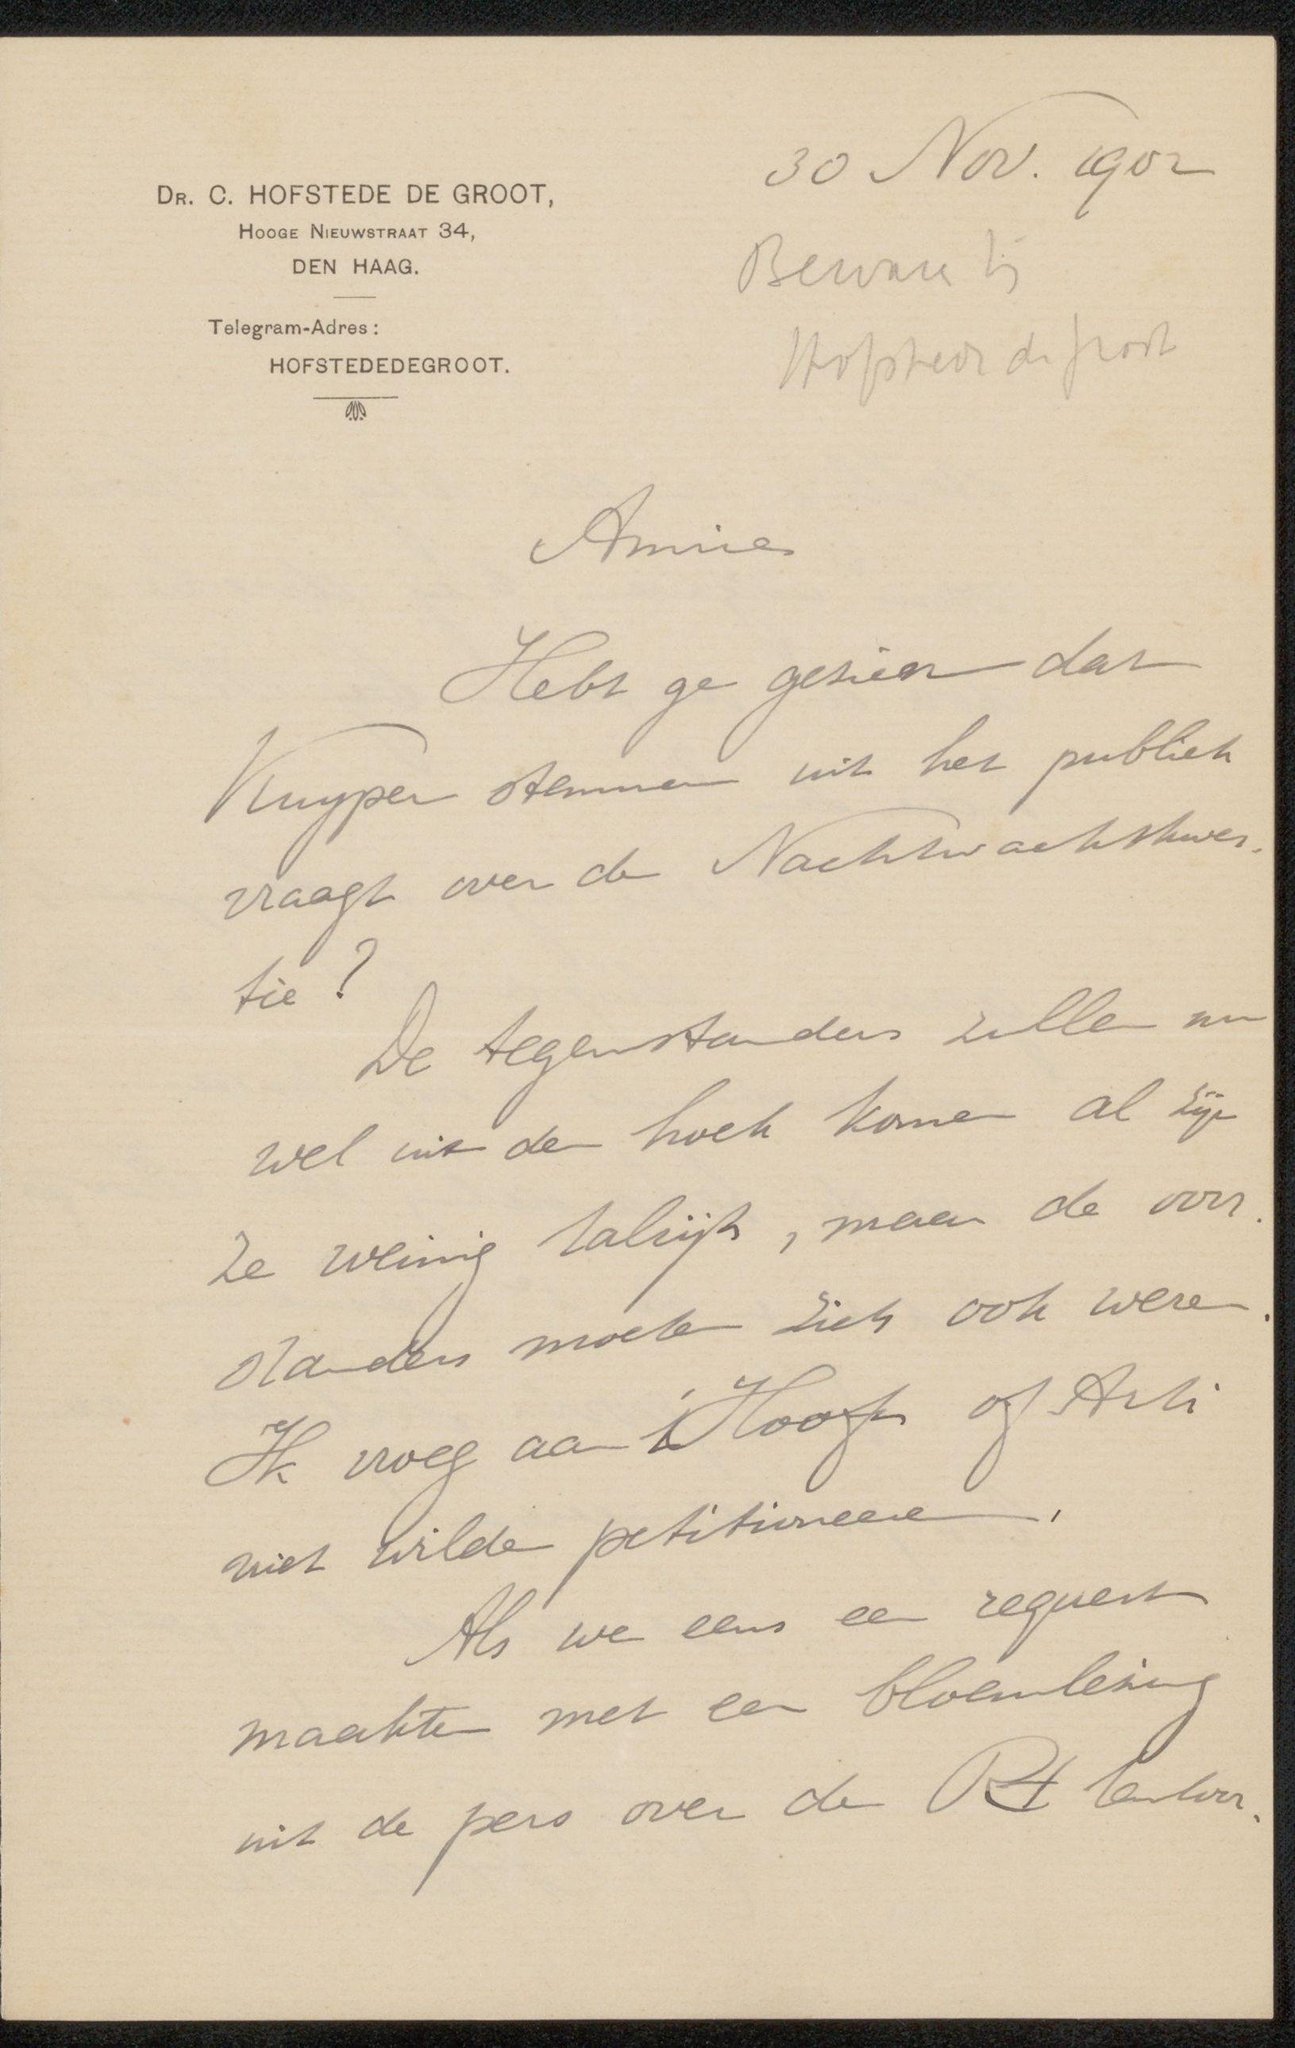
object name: letter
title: Brief aan Jan Veth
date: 1902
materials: ink, paper, pencil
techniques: pen, printing, writing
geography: the hague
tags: dordrecht, painter, print maker, draughtsman, designer, jan veth, leiden, rembrandt van rijn, cornelis gerardus 't hooft, painting (including book-illumination, miniature-painting), plan ~ architecture, printed matter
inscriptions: collector's mark: ‘RPK’